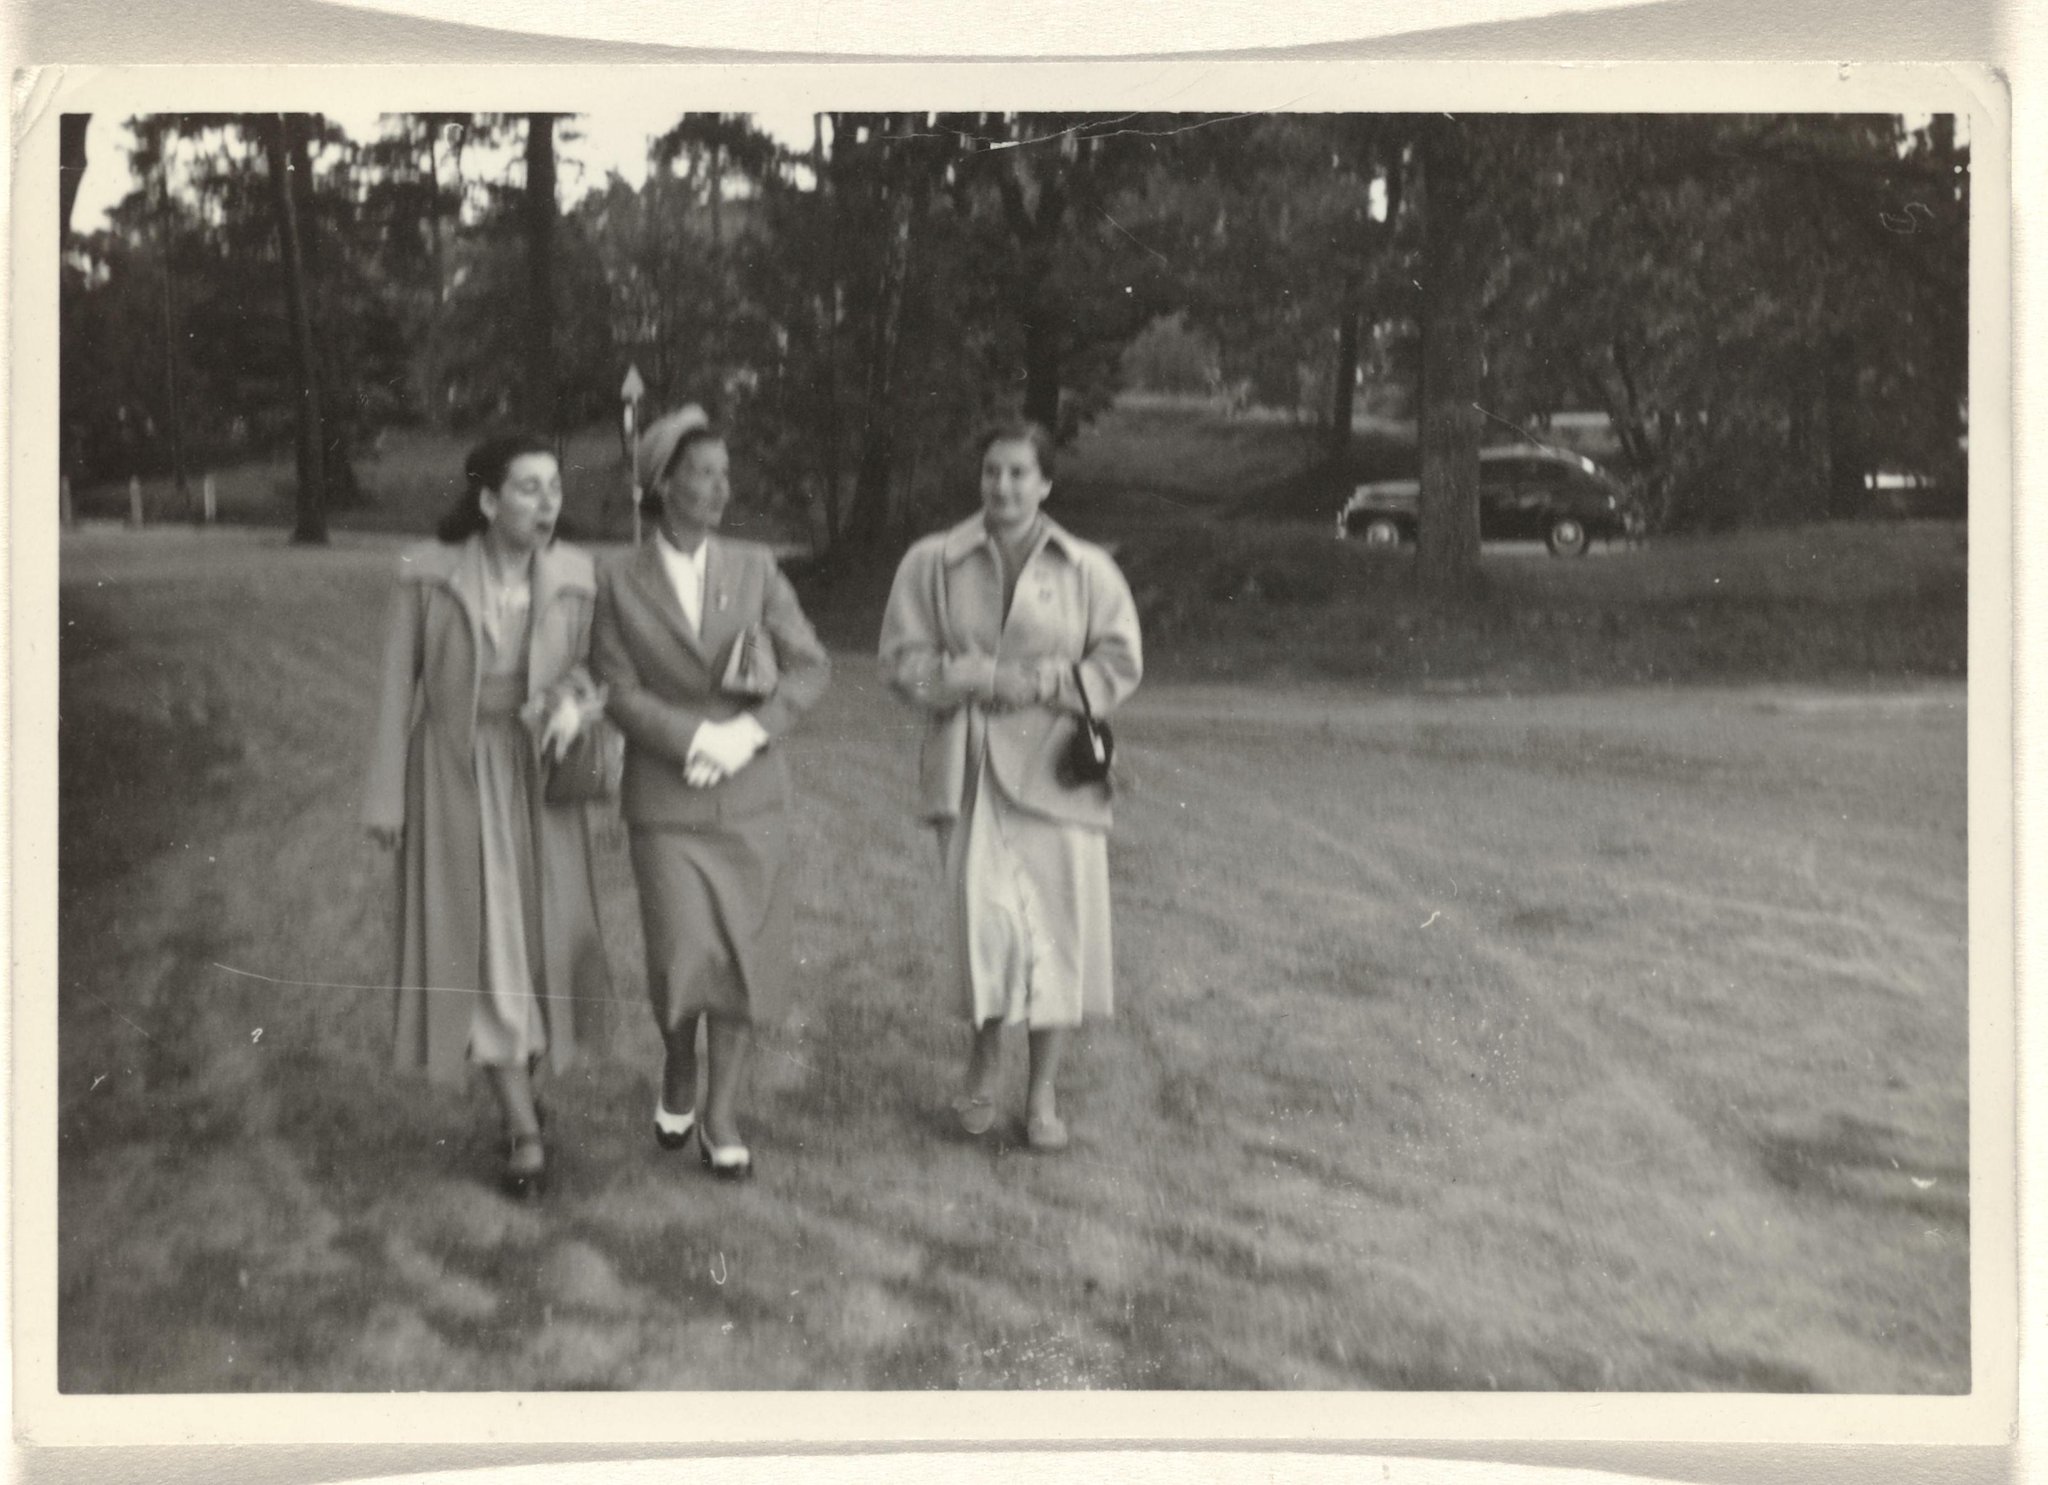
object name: photograph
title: Isabel Wachenheimer in lange jas en twee onbekende vrouwen, lopend over een grasveld met bomen en een auto op de achtergrond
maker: Anonymous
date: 1946-1963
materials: photographic support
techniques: gelatin silver print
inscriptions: number: ‘2/11’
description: Isabel Wachenheimer (rechts) in lange lichte jas en twee onbekende vrouwen, lopend over een grasveld met bomen en een auto op de achtergrond.